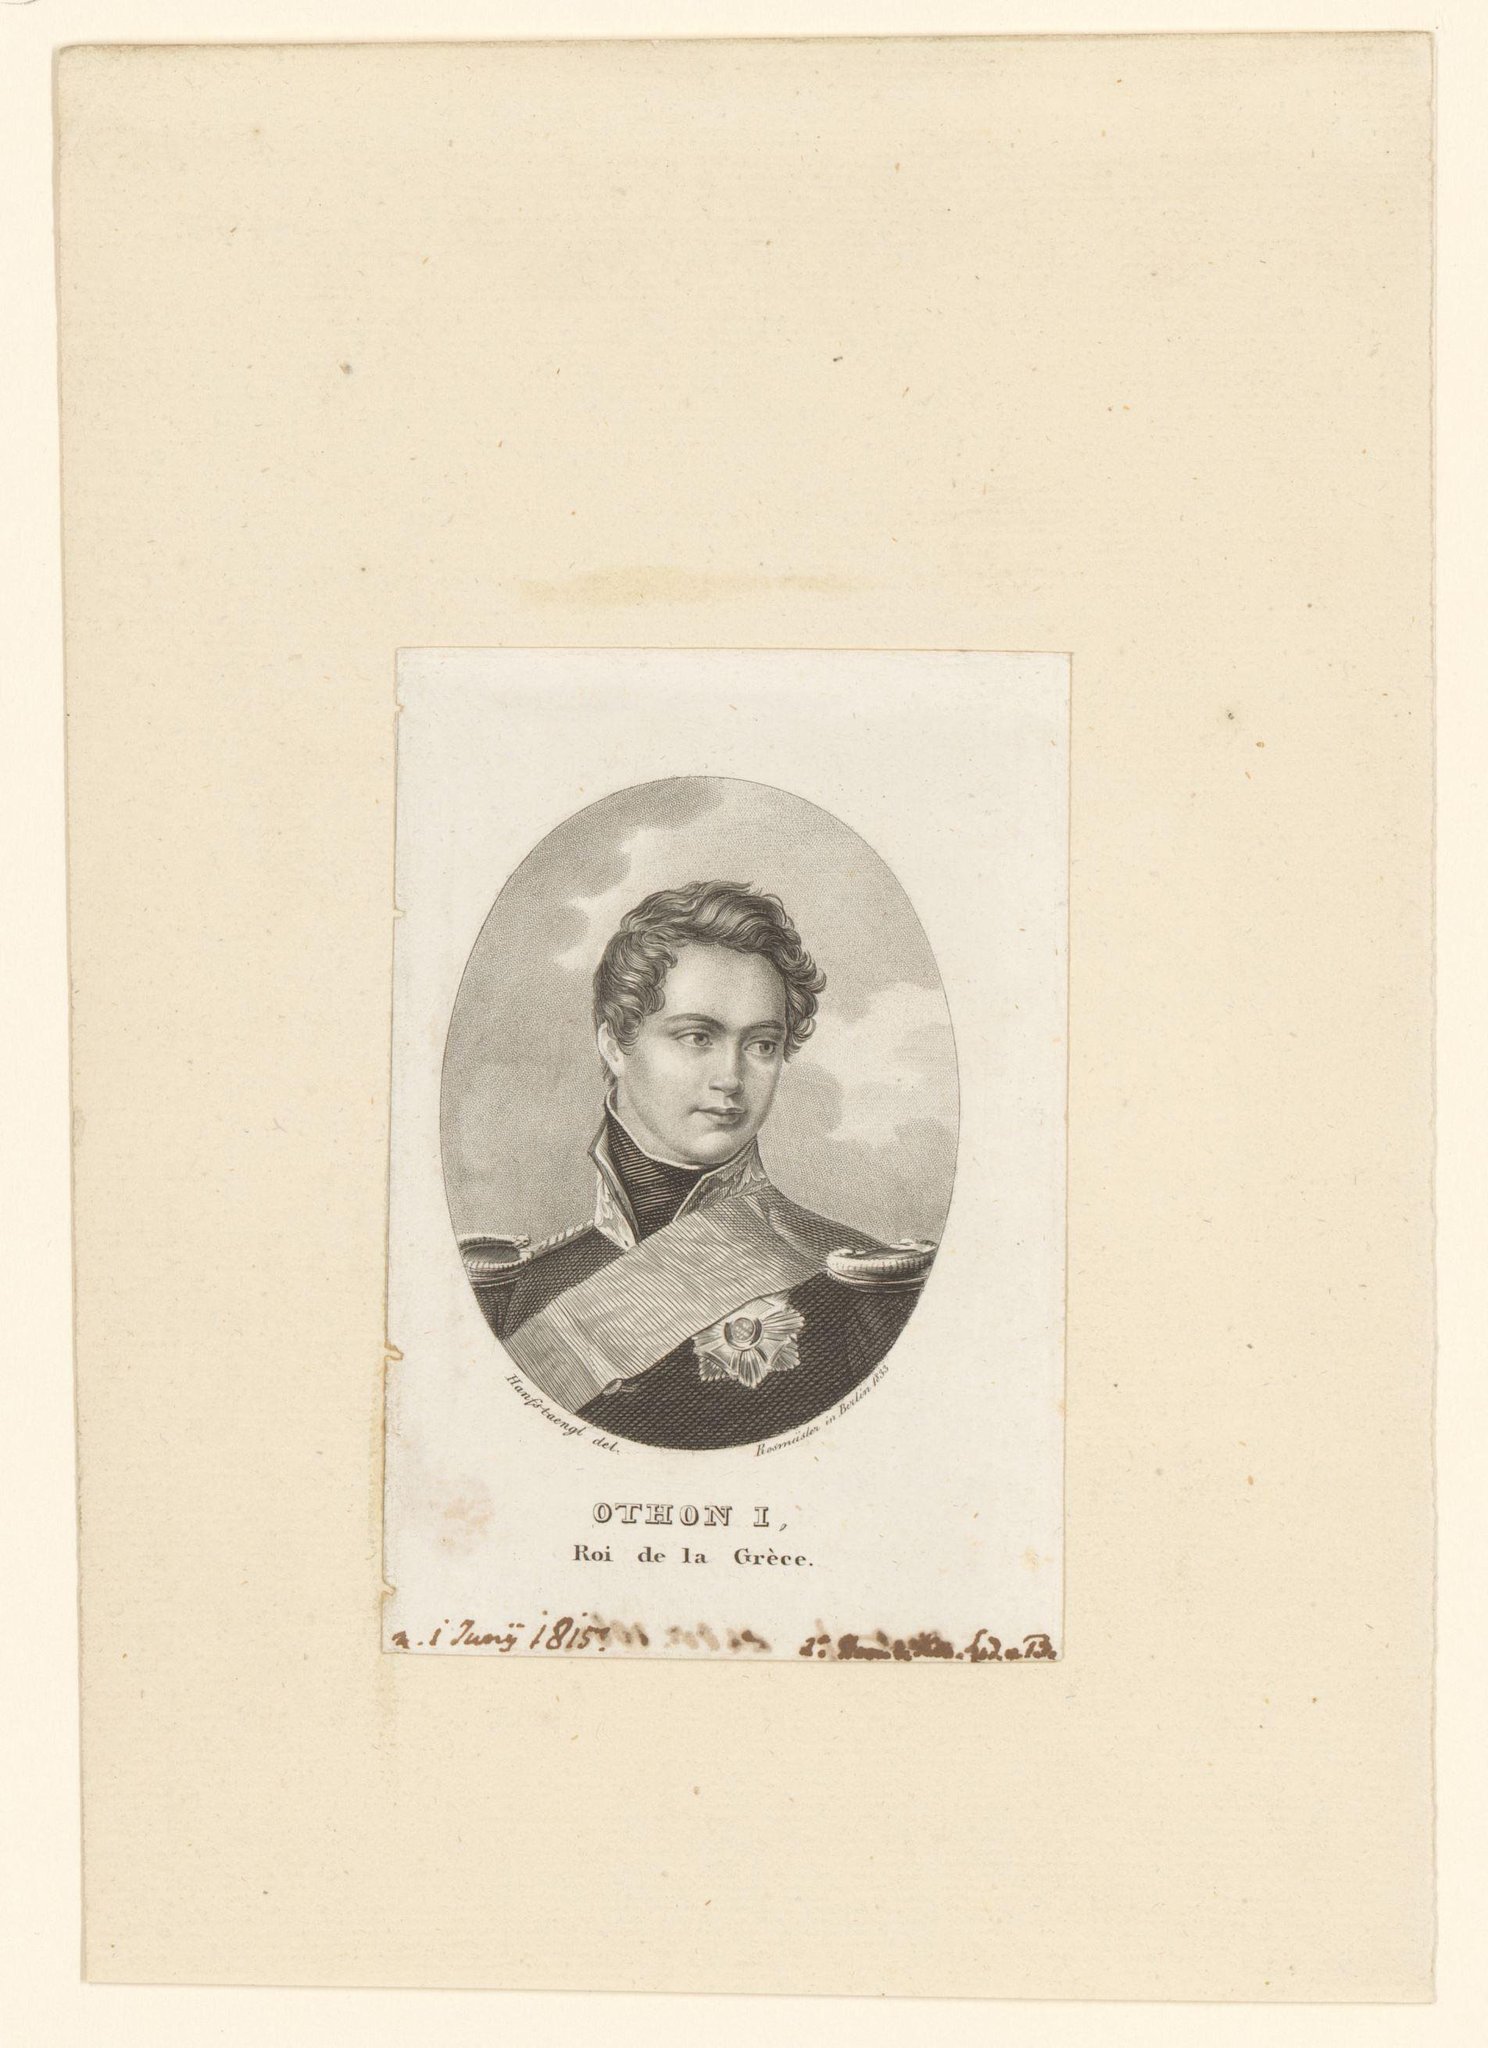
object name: print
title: Portret van Otto I, koning van Griekenland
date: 1833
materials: paper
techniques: engraving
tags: historical persons, medals and other marks of military honour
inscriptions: collector's mark: Lugt 2228